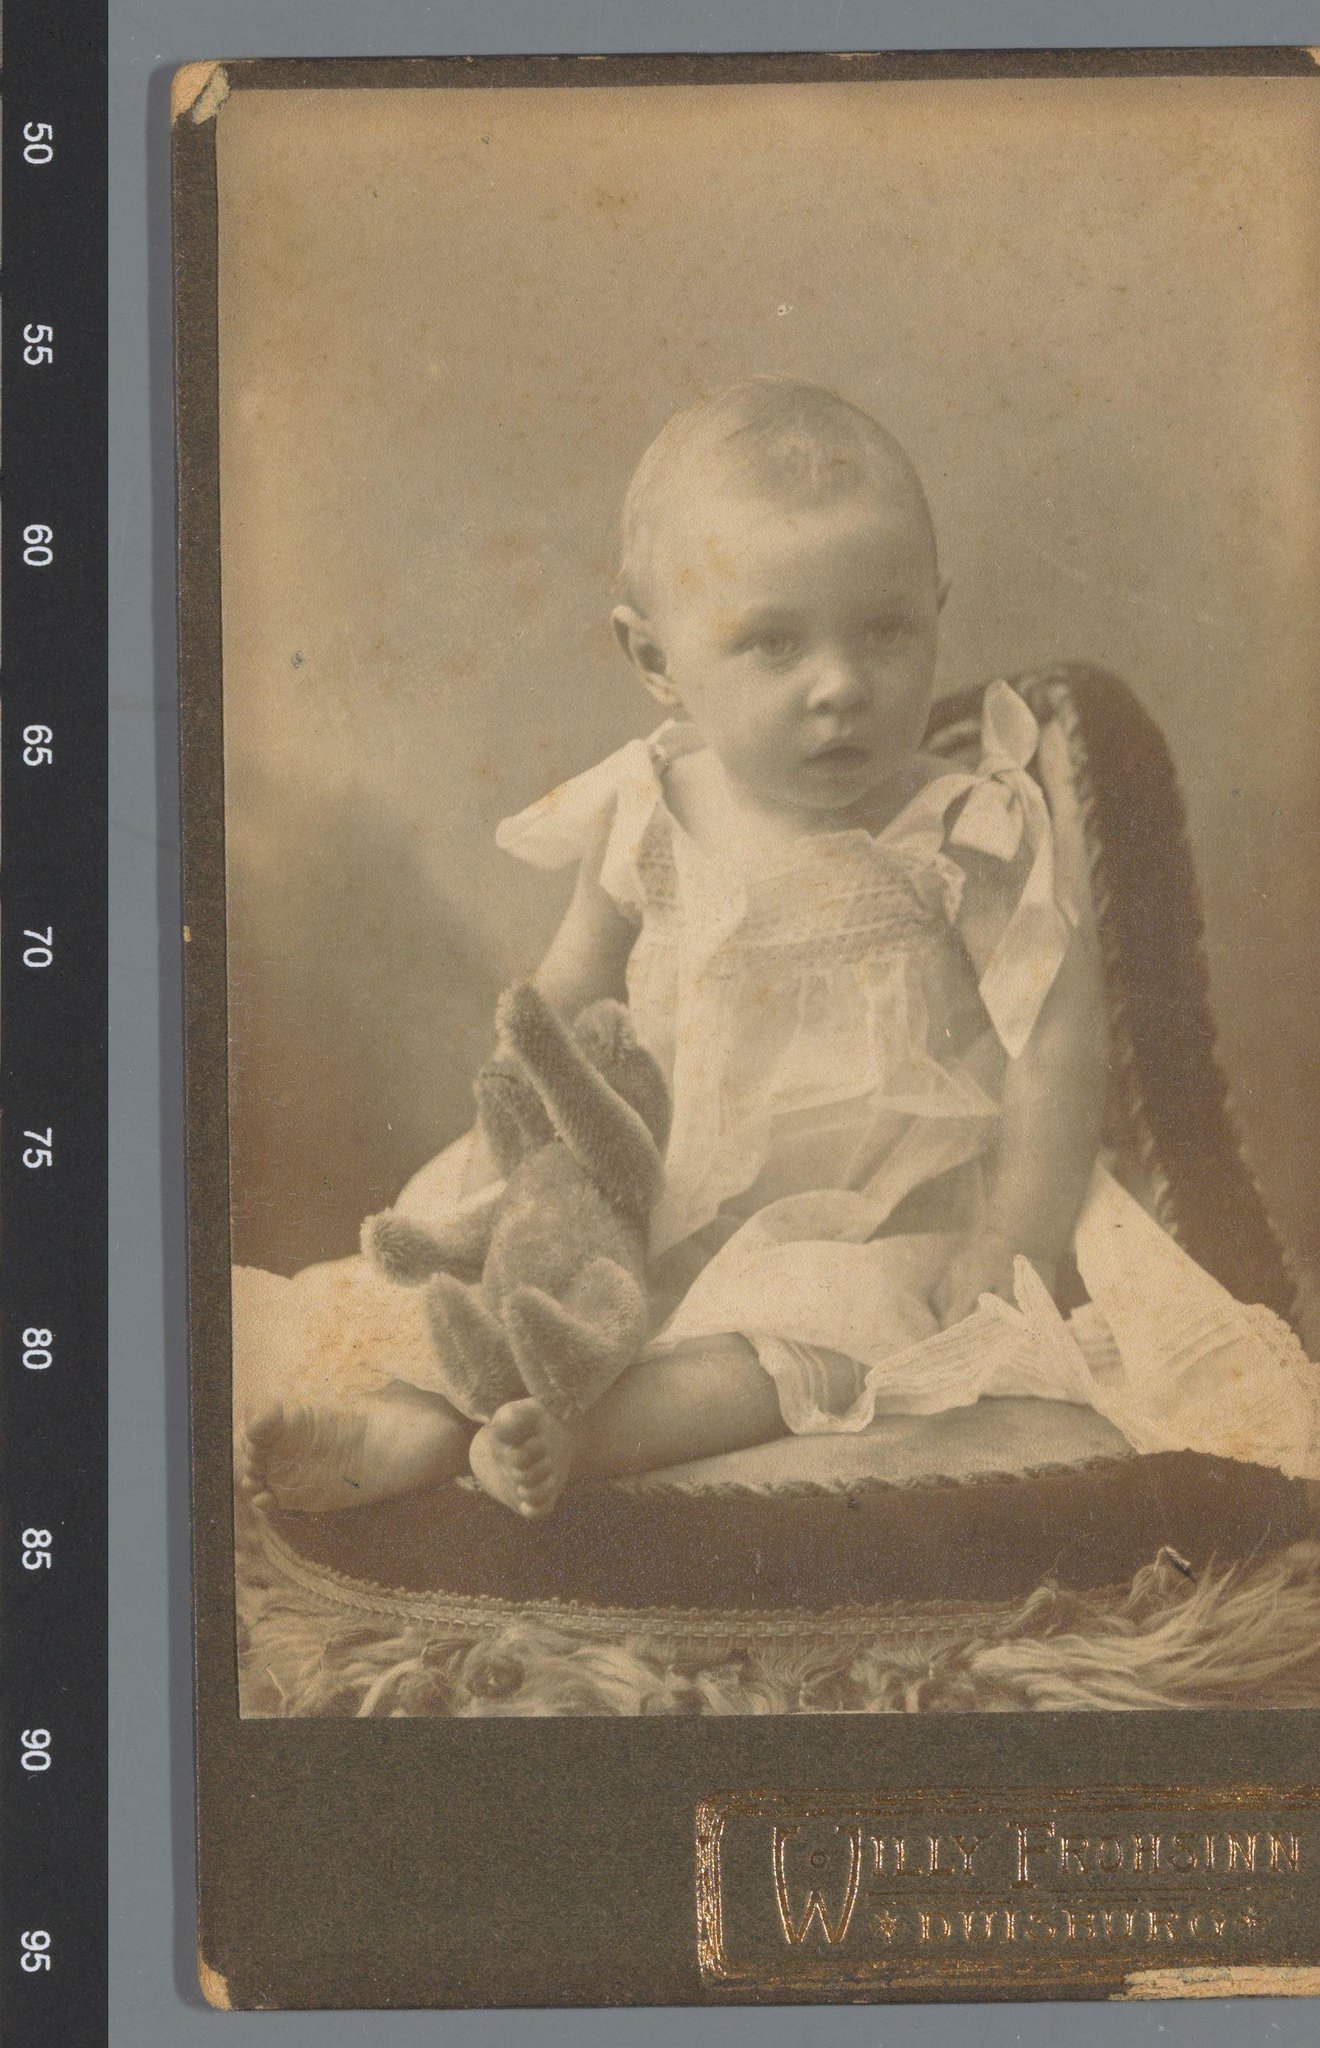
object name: carte de visite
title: Portret van een onbekende baby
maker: willy frohsinn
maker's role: fotograaf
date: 1900-1914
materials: paper, cardboard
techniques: gelatin silver print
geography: duisburg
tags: anonymous historical person portrayed, infant, baby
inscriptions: address: ‘Duisburg/ Königstrasse/ ...26...’, inscription: ‘Vergrösserungen nach jedem/ Bilde./ Die Platte bleibt für/ Nachbestellungen aufbewahrt.’